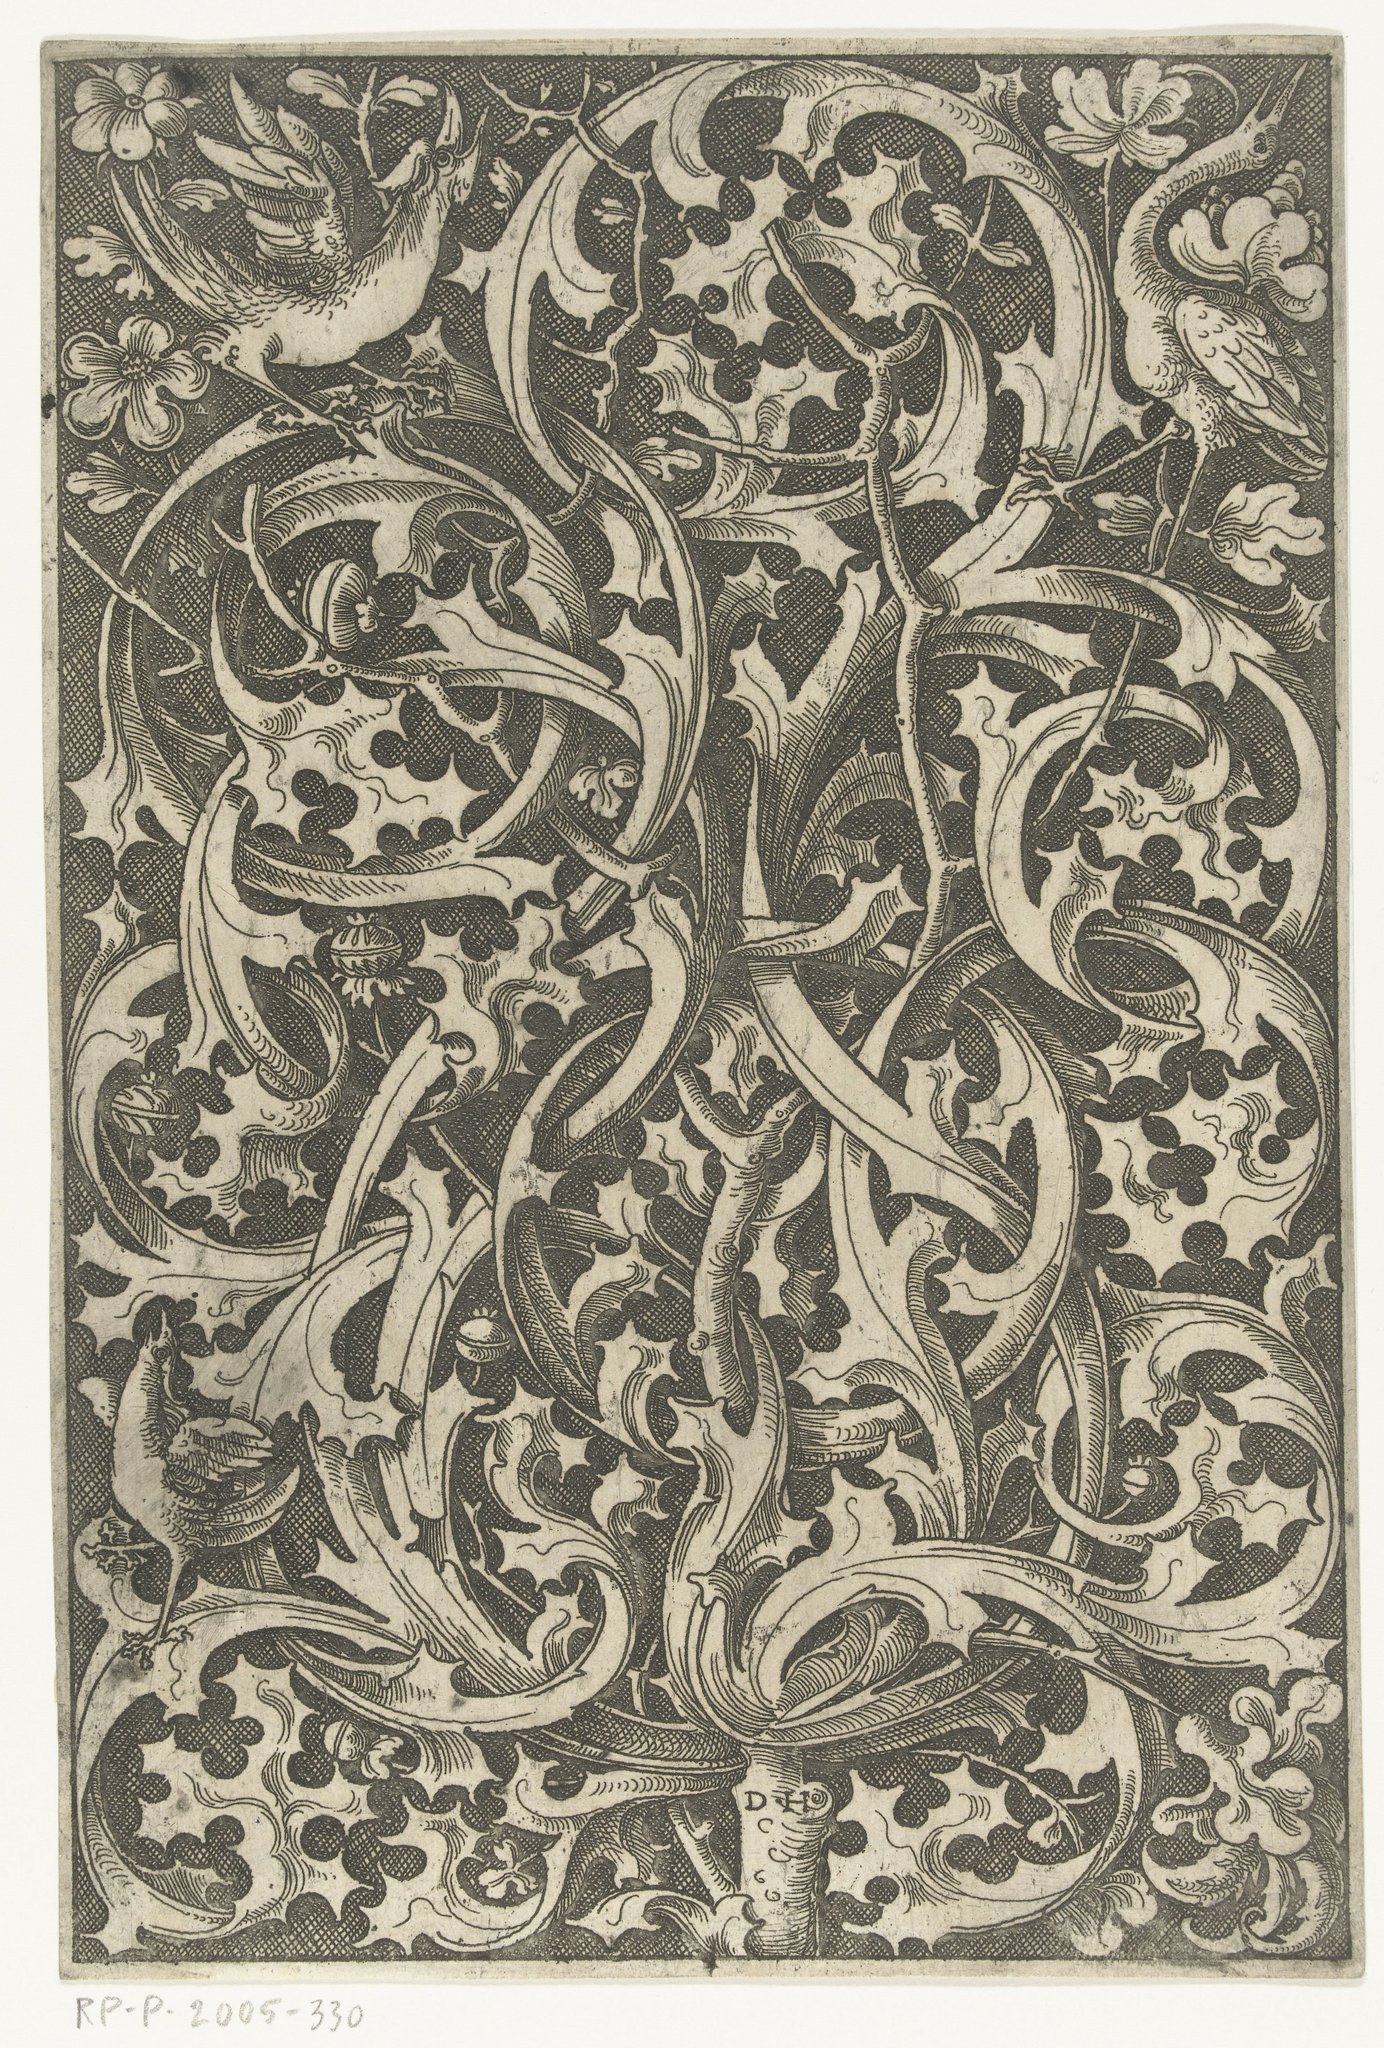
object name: ornament print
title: Ornamentblad met distelmotieven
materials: paper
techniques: etching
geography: germany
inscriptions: inscription: ‘Akanthus-Ornament mit drei vogeln u einer Schnecke: B. 93,I (v. 2) v.d. Nv. 137’